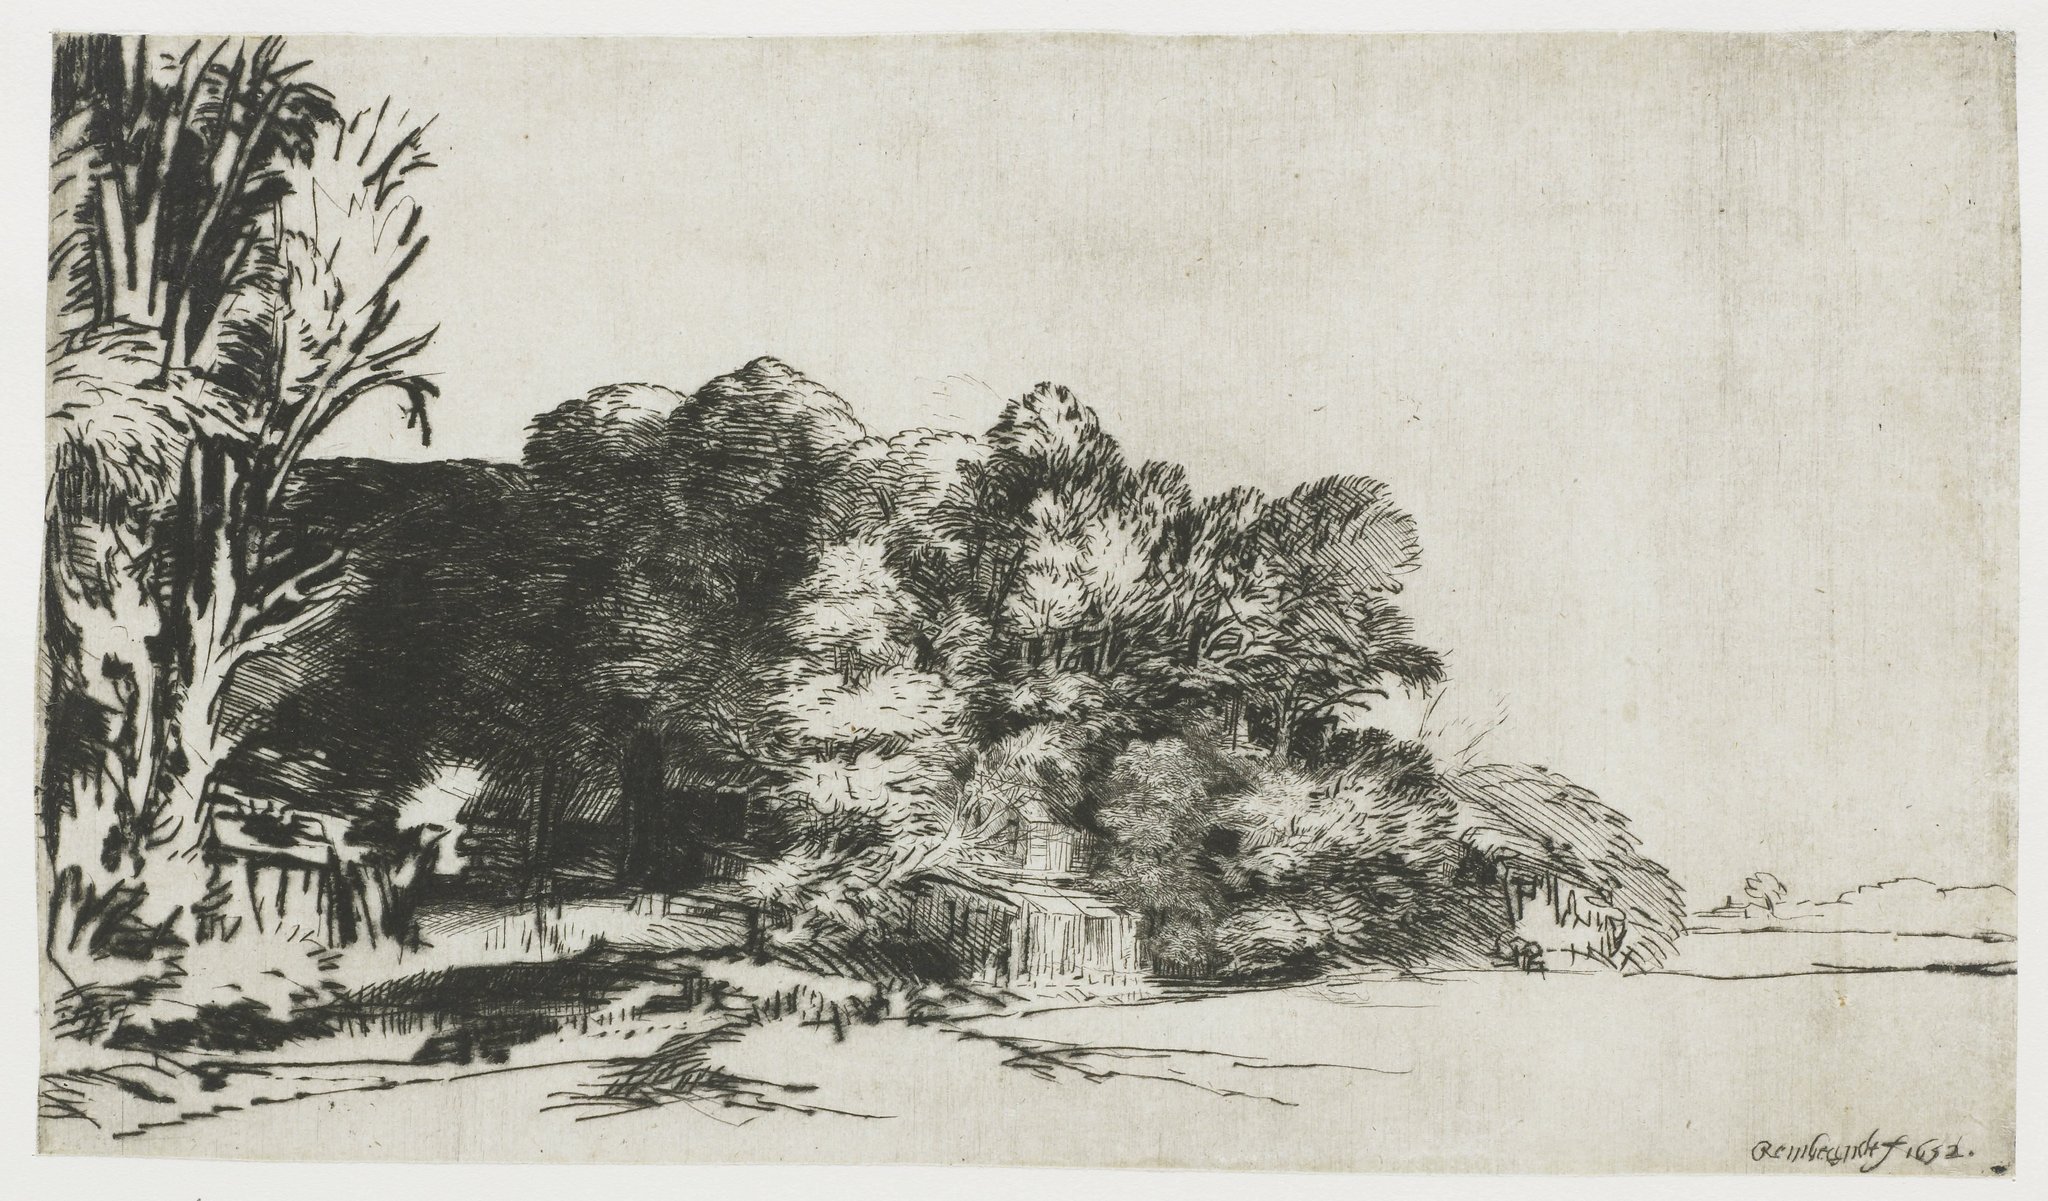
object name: print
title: Clump of trees with a vista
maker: rembrandt van rijn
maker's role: draughtsman, painter, print maker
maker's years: 1606-1669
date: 1652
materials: paper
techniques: drypoint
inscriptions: signature and date: ‘Rembrandt f 1652’, collector's mark: Lugt 2228